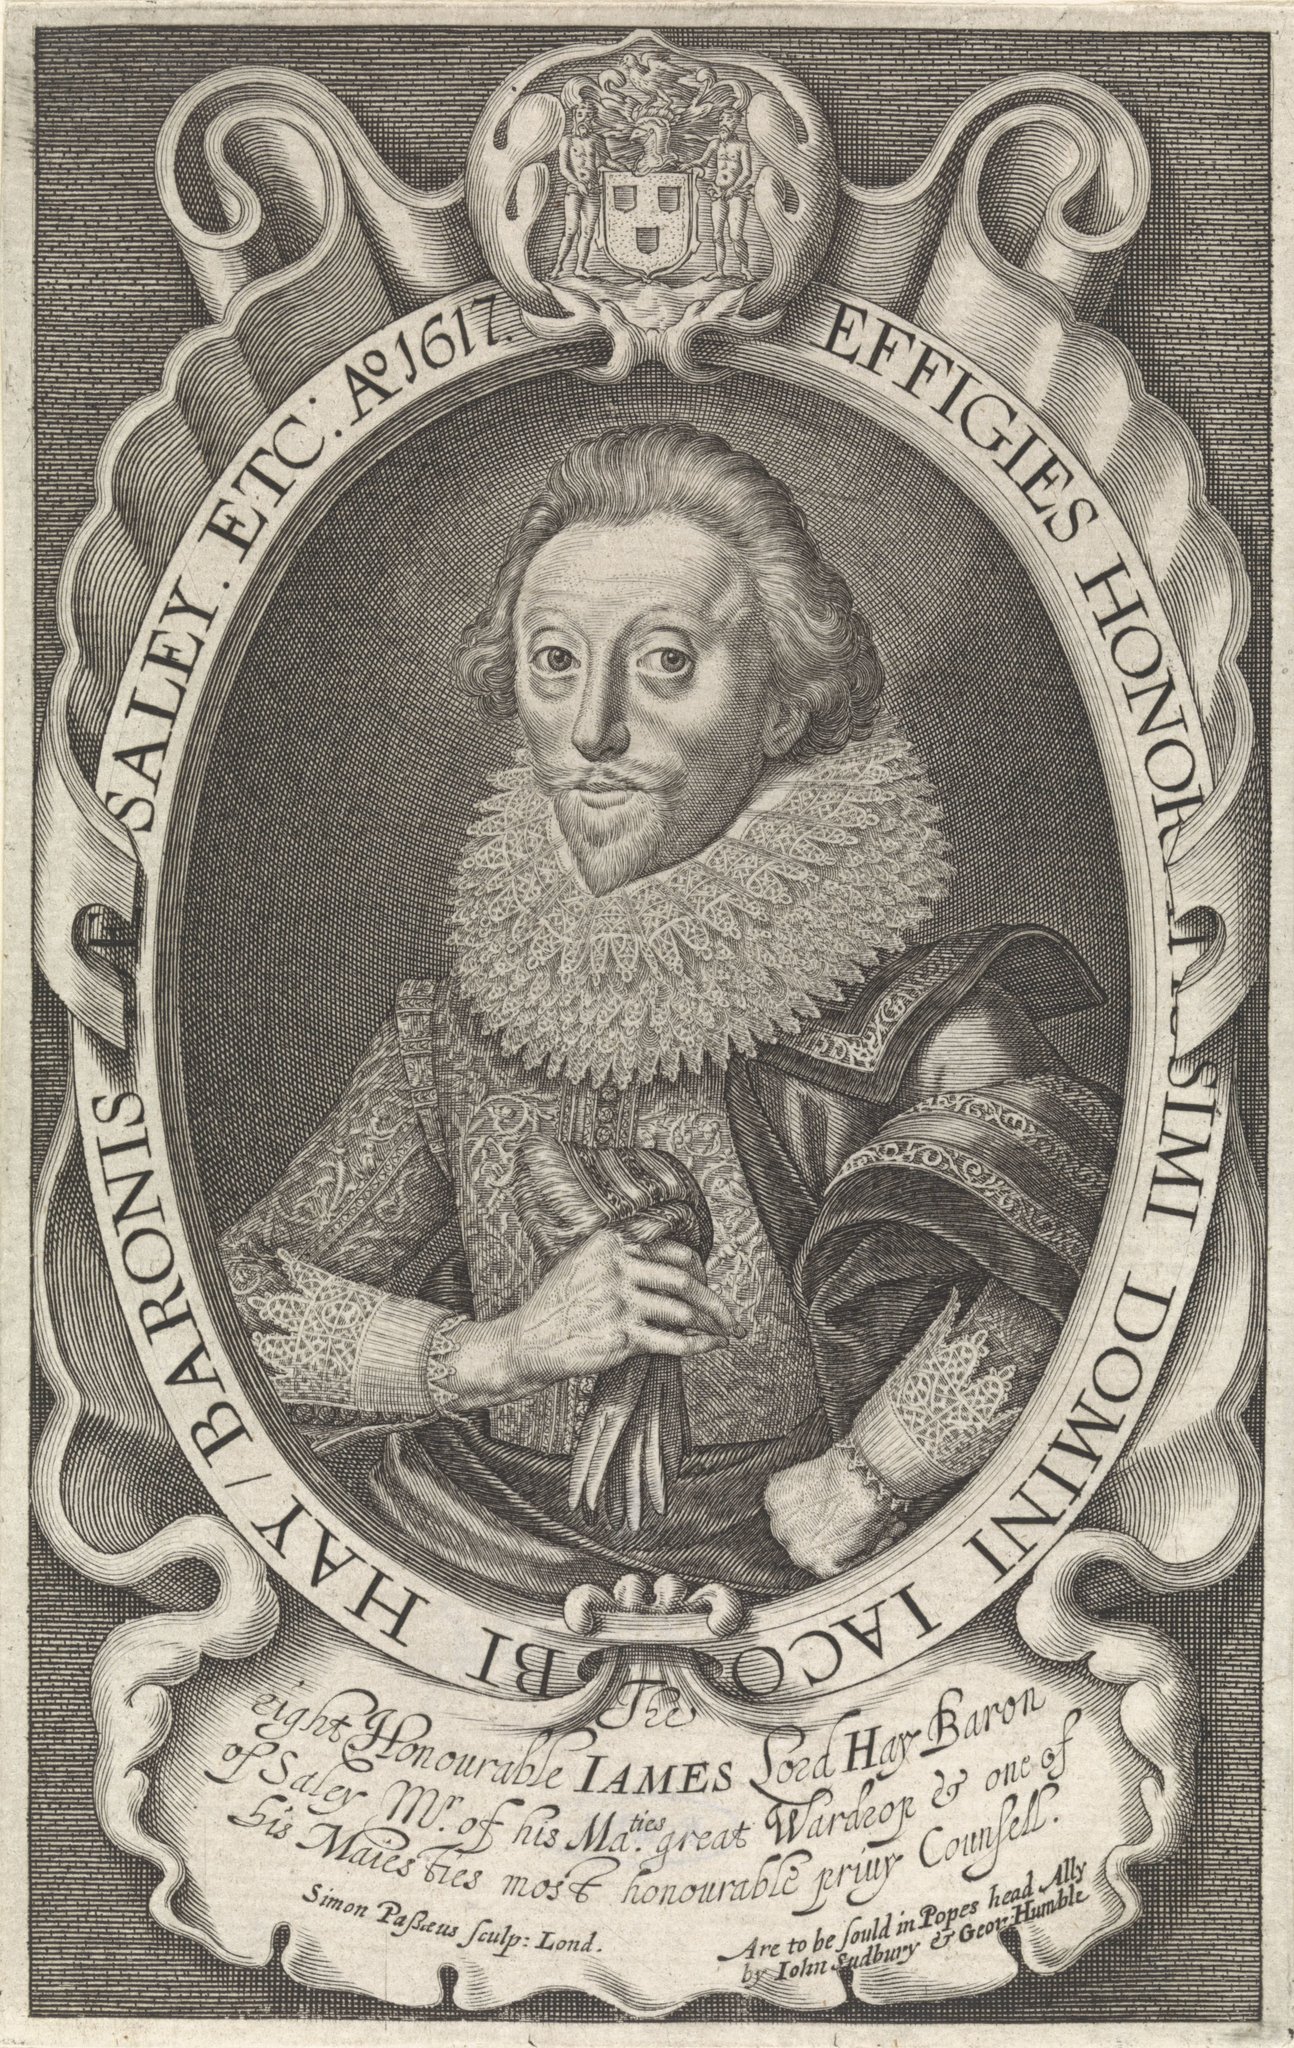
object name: print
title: Portret van James Hay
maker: simon van de passe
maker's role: print maker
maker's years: 1595-1647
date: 1617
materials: paper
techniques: engraving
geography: london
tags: james hay (hertog van carlisle)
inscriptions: collector's mark: Lugt 2228, collector's mark: Lugt 2760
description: Portret van de Schotse aristocraat James Hay, hertog van Carlisle, met zijn wapenschild. In een cartouche een vierregelig lofdicht in het Engels.